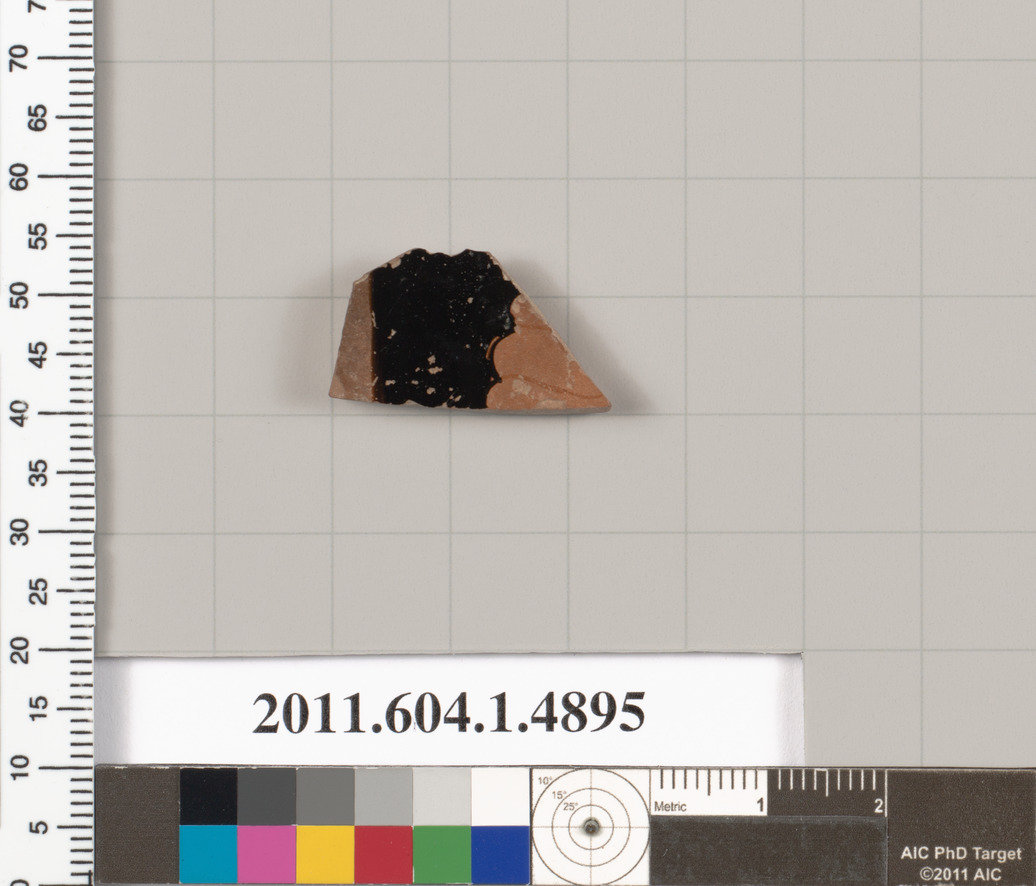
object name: kylix fragment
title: Terracotta fragment of a kylix (drinking cup)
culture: greek, attic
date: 490-470 BCE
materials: terracotta